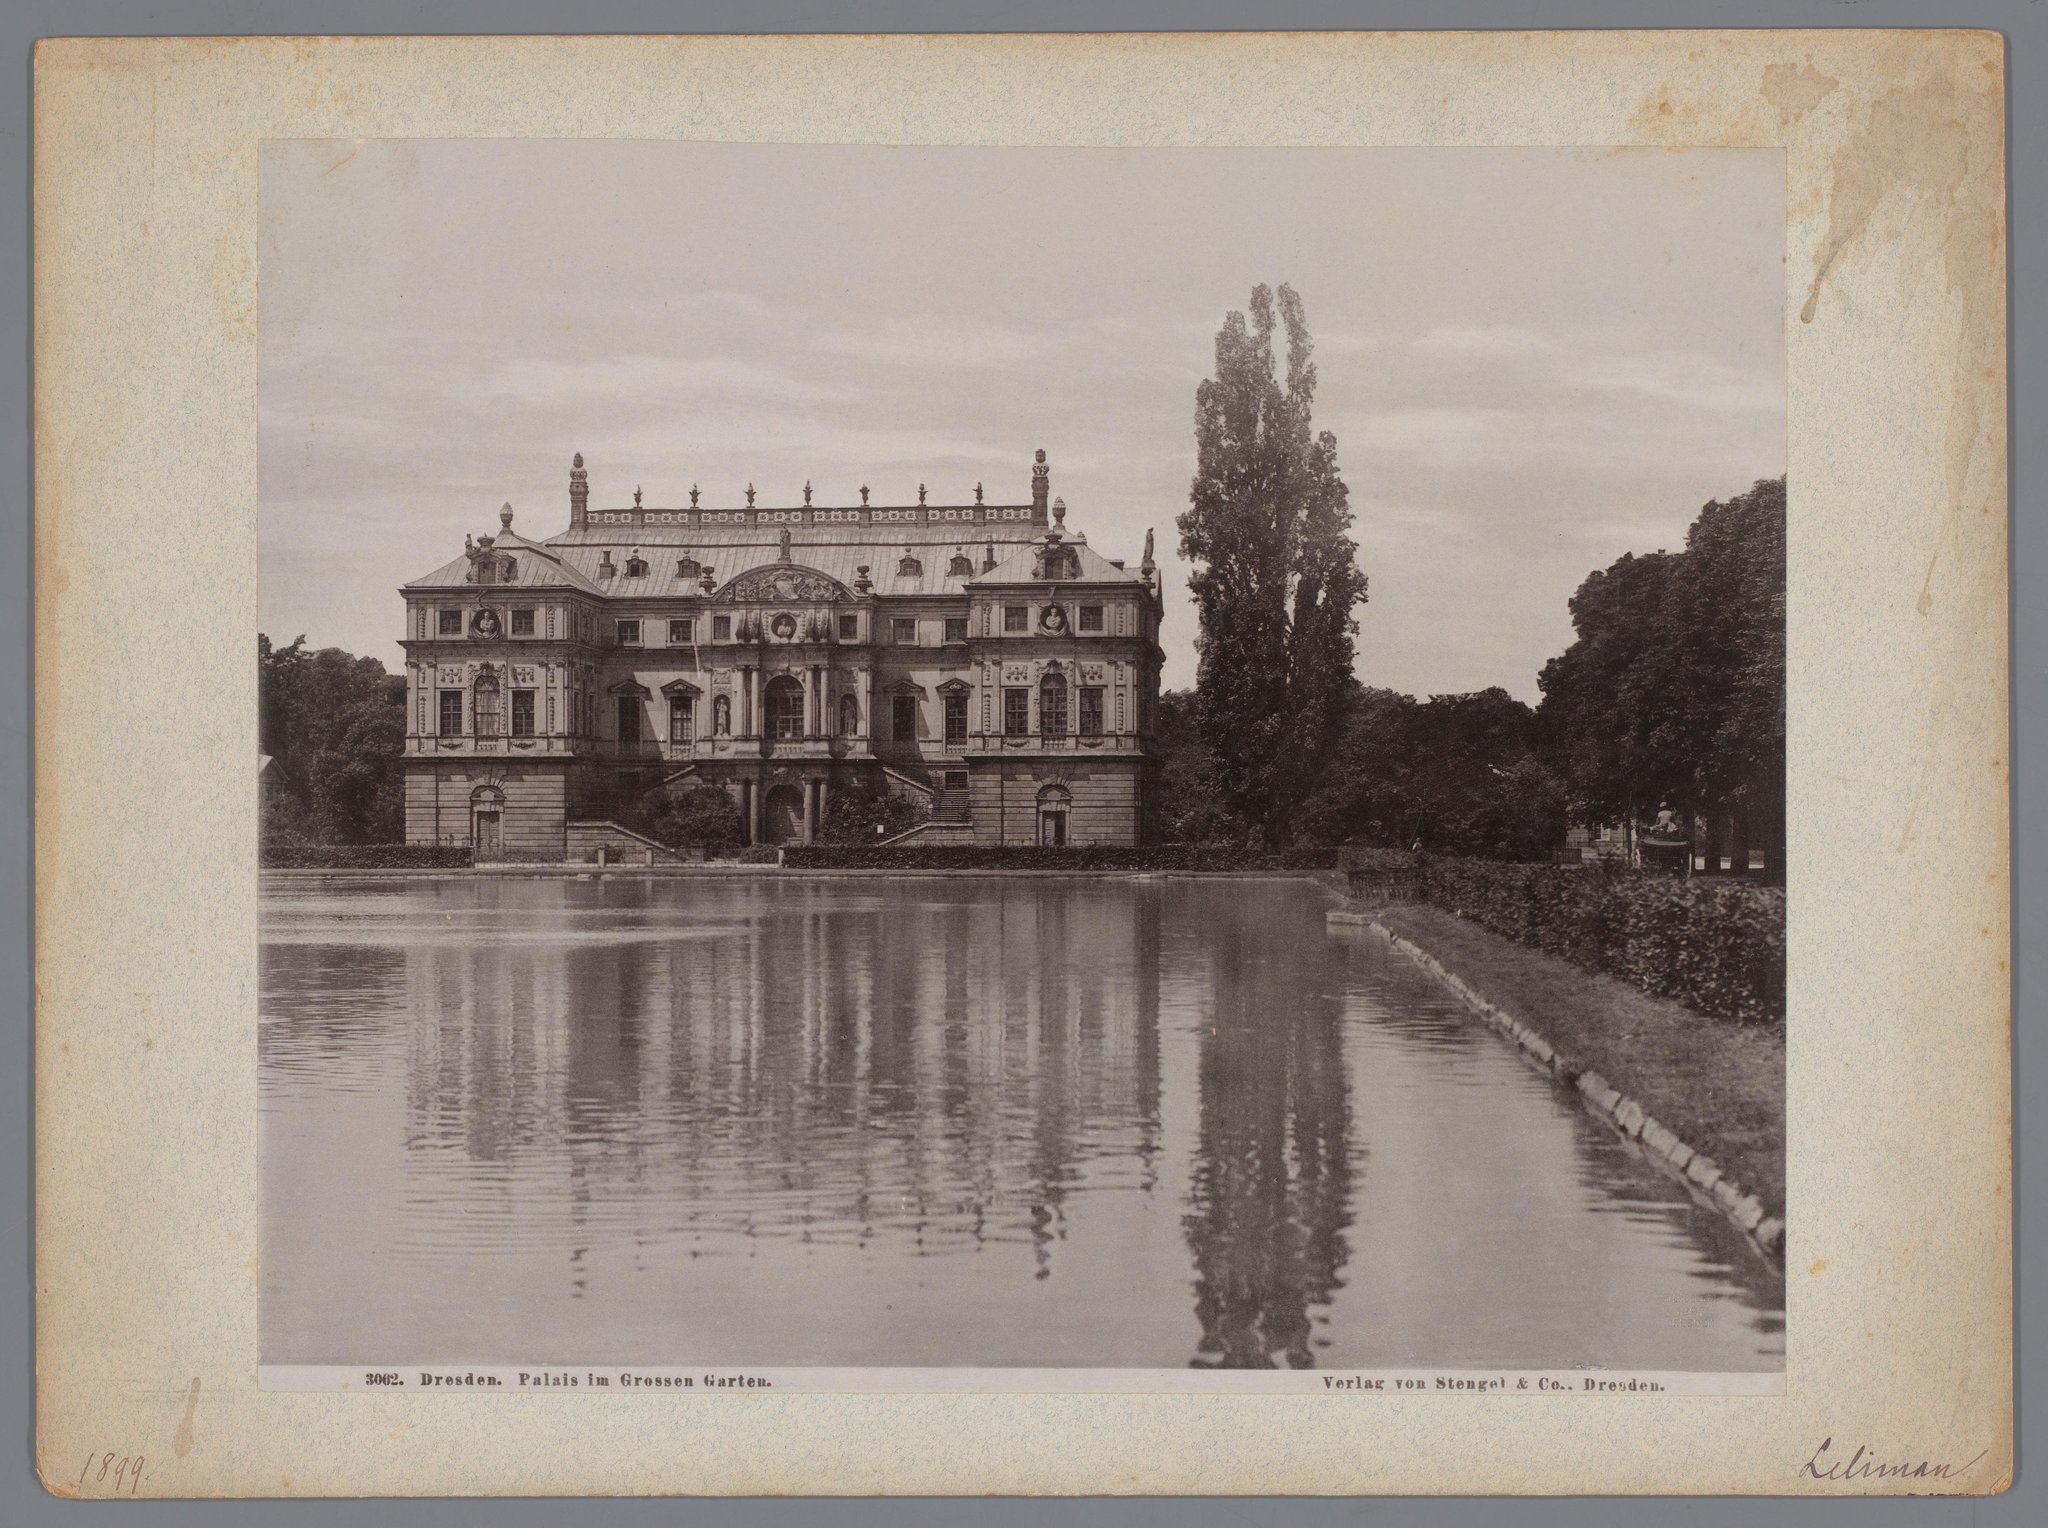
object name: photomechanical print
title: Dresden, Palais im Grossen Garten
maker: Anonymous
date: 1889-1930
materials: cardboard, paper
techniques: photograph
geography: dresden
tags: palace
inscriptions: number: ‘3062.’, inscription: ‘BOEKERIJ/ LELIMAN’